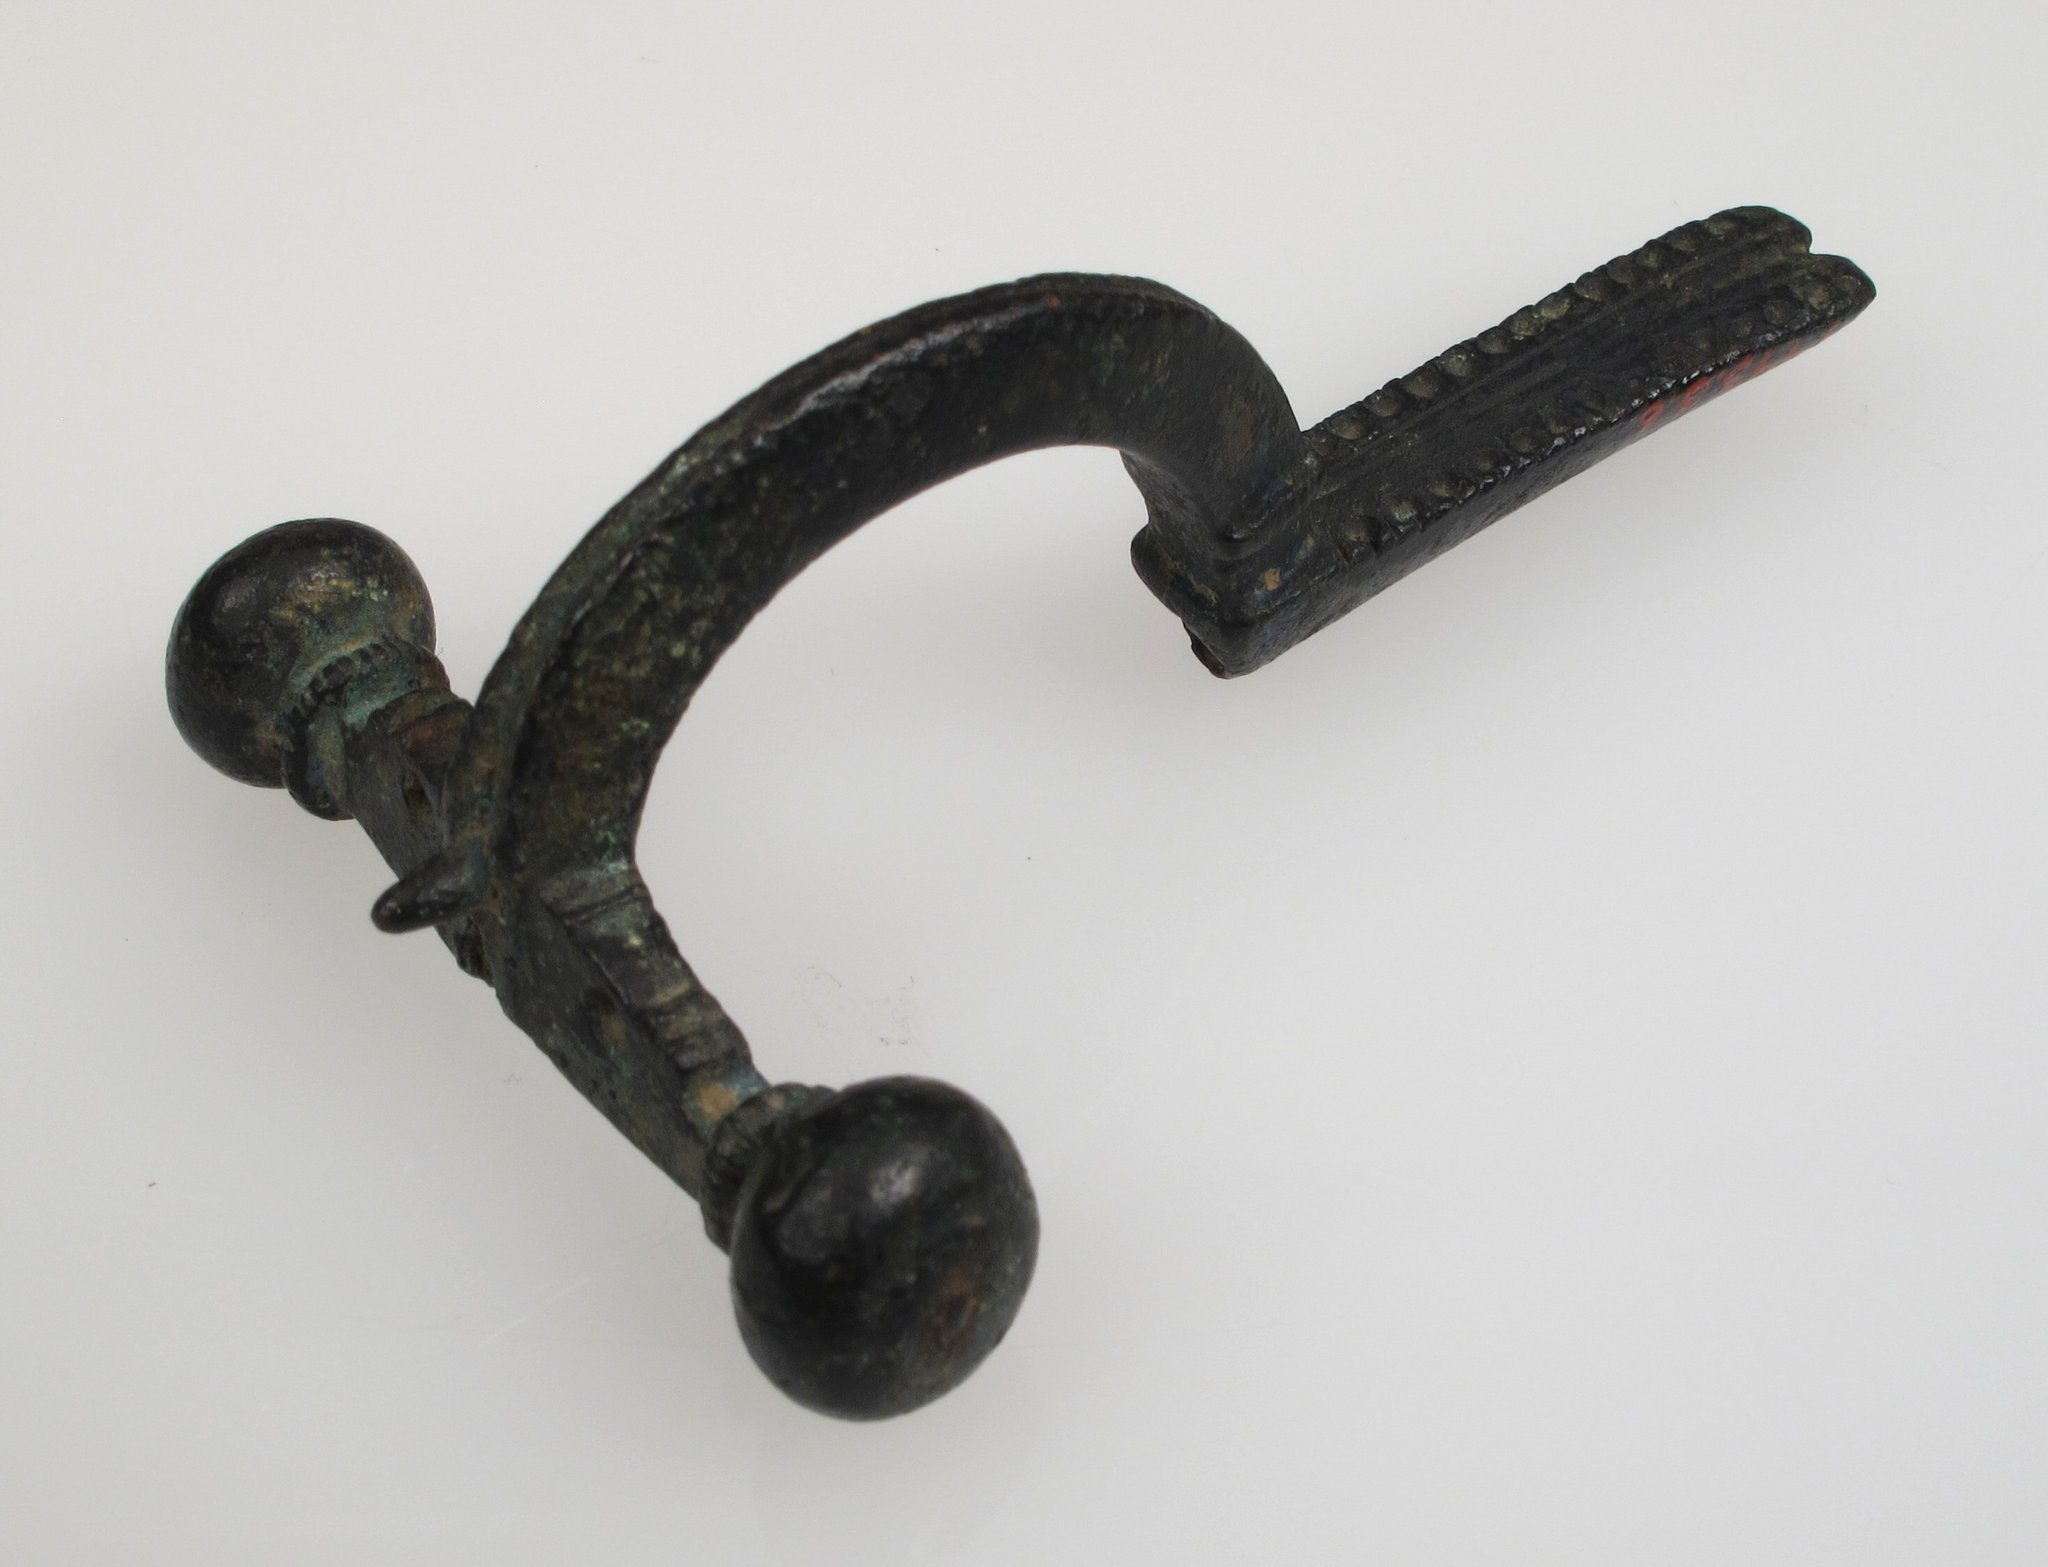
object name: brooch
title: Crossbow Fibula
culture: roman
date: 350-380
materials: copper alloy